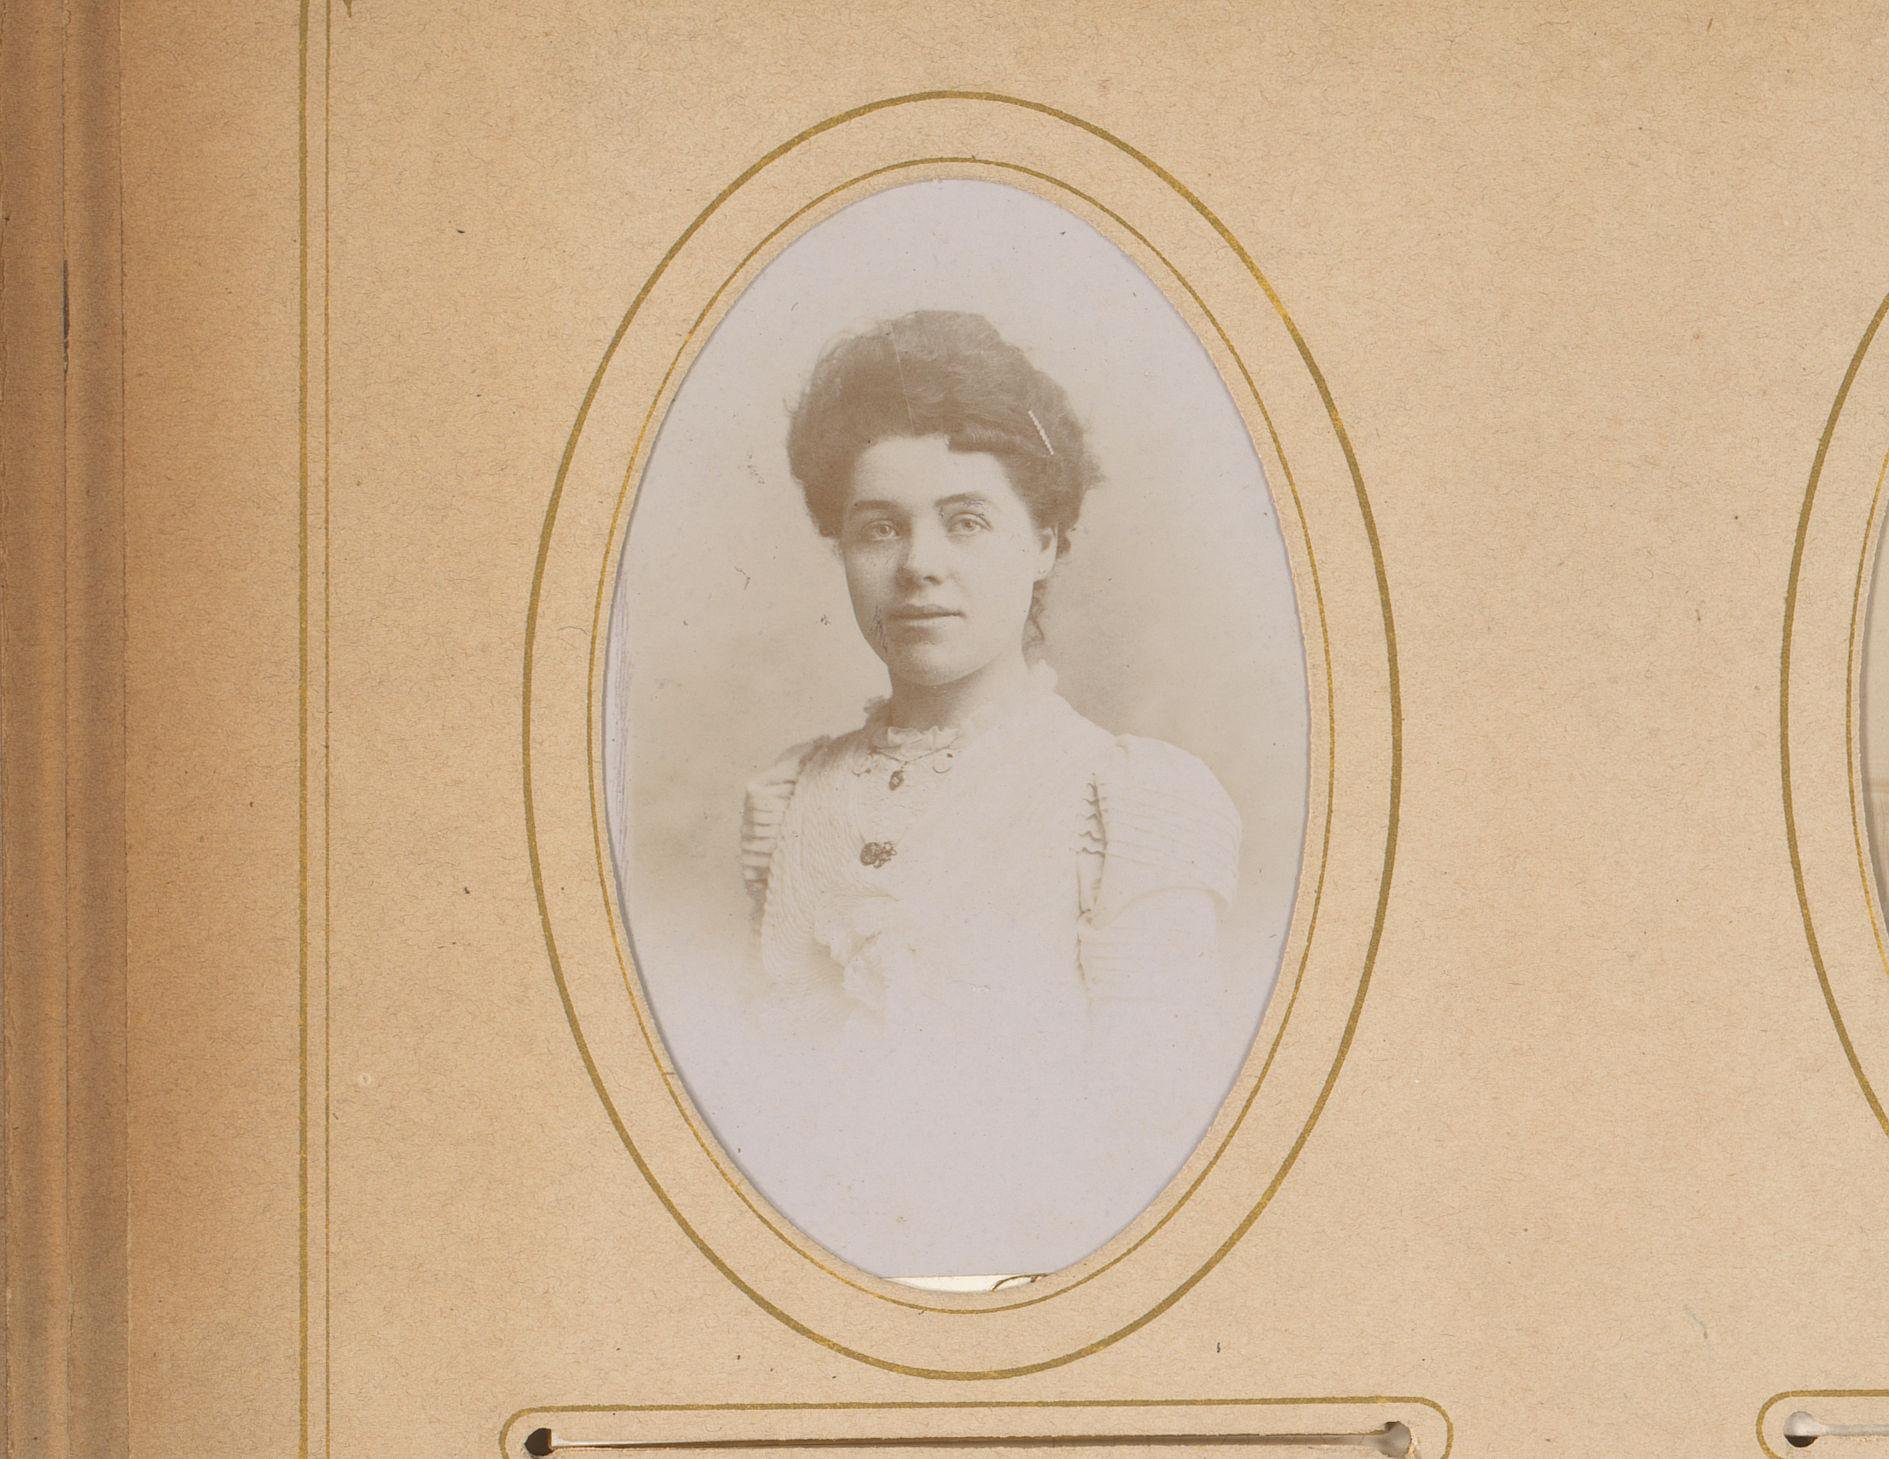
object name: carte de visite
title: Portret van een vrouw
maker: Anonymous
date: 1870-1900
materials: cardboard, photographic support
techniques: collodion silver print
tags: adult woman, historical persons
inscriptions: name: ‘[...]’